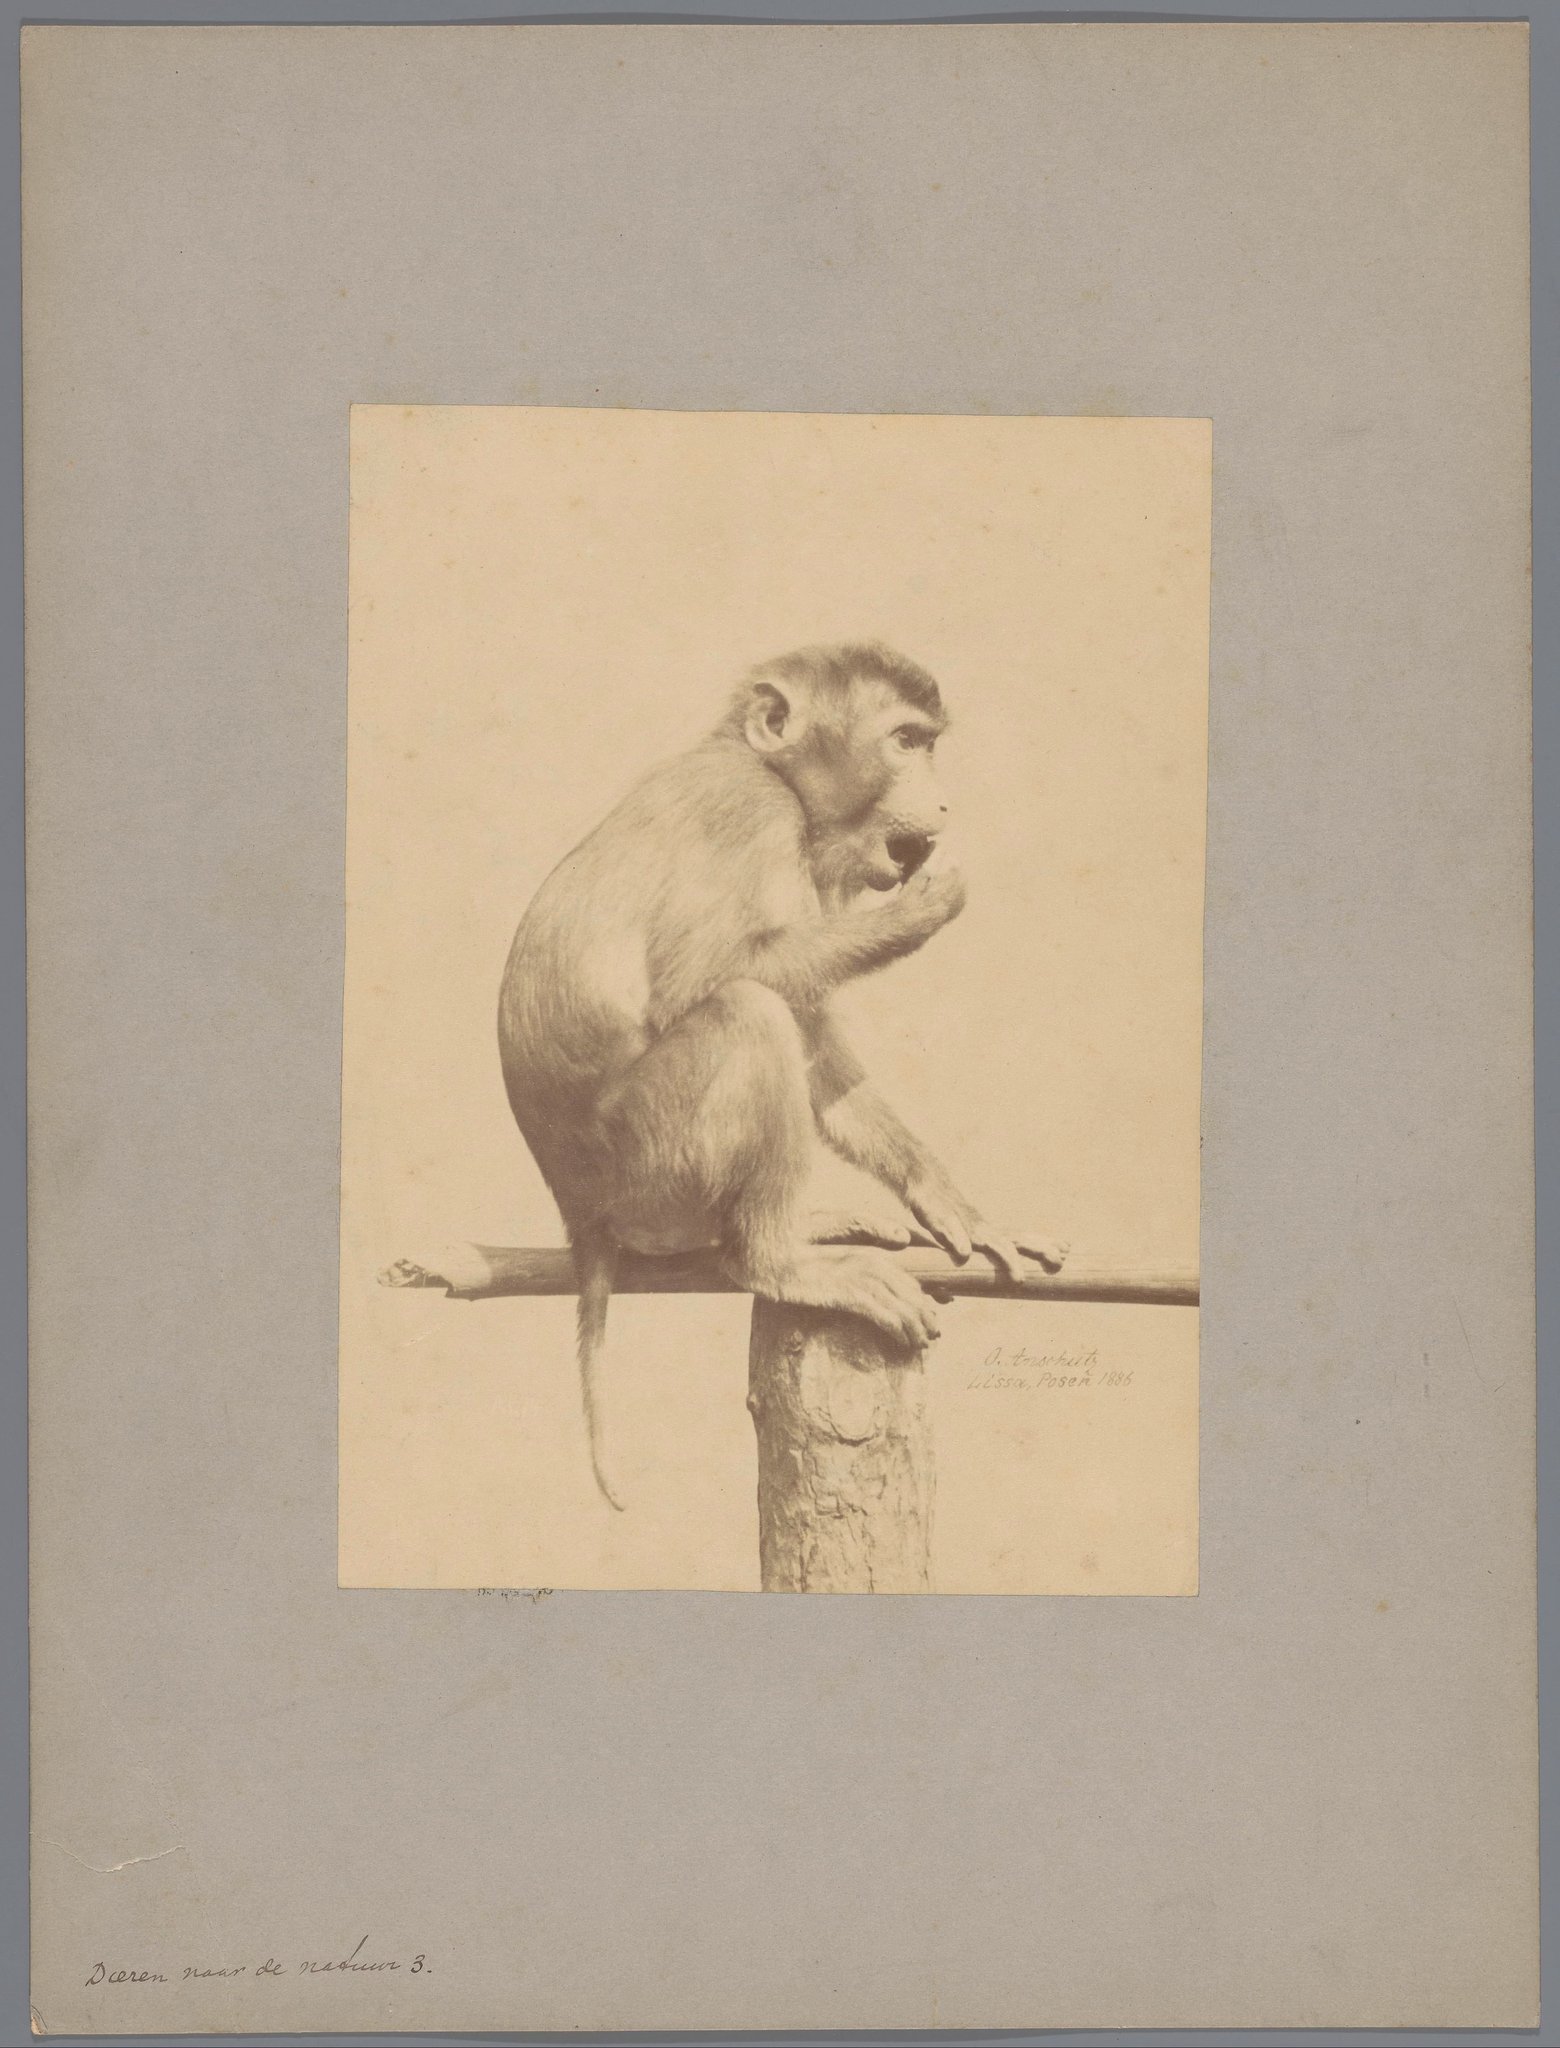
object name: photograph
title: Aap op een stok die iets in de bek stopt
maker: ottomar anschütz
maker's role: fotograaf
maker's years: 1846-1907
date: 1886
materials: cardboard, photographic support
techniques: albumen print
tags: monkeys, apes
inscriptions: collector's mark: ‘RIJKS-NORMAALSCHOOL-VOOR-TEEKENONDERWIJZERS-AMSTERDAM’, name: ‘O. Anschütz Lissa, Posen 1886’